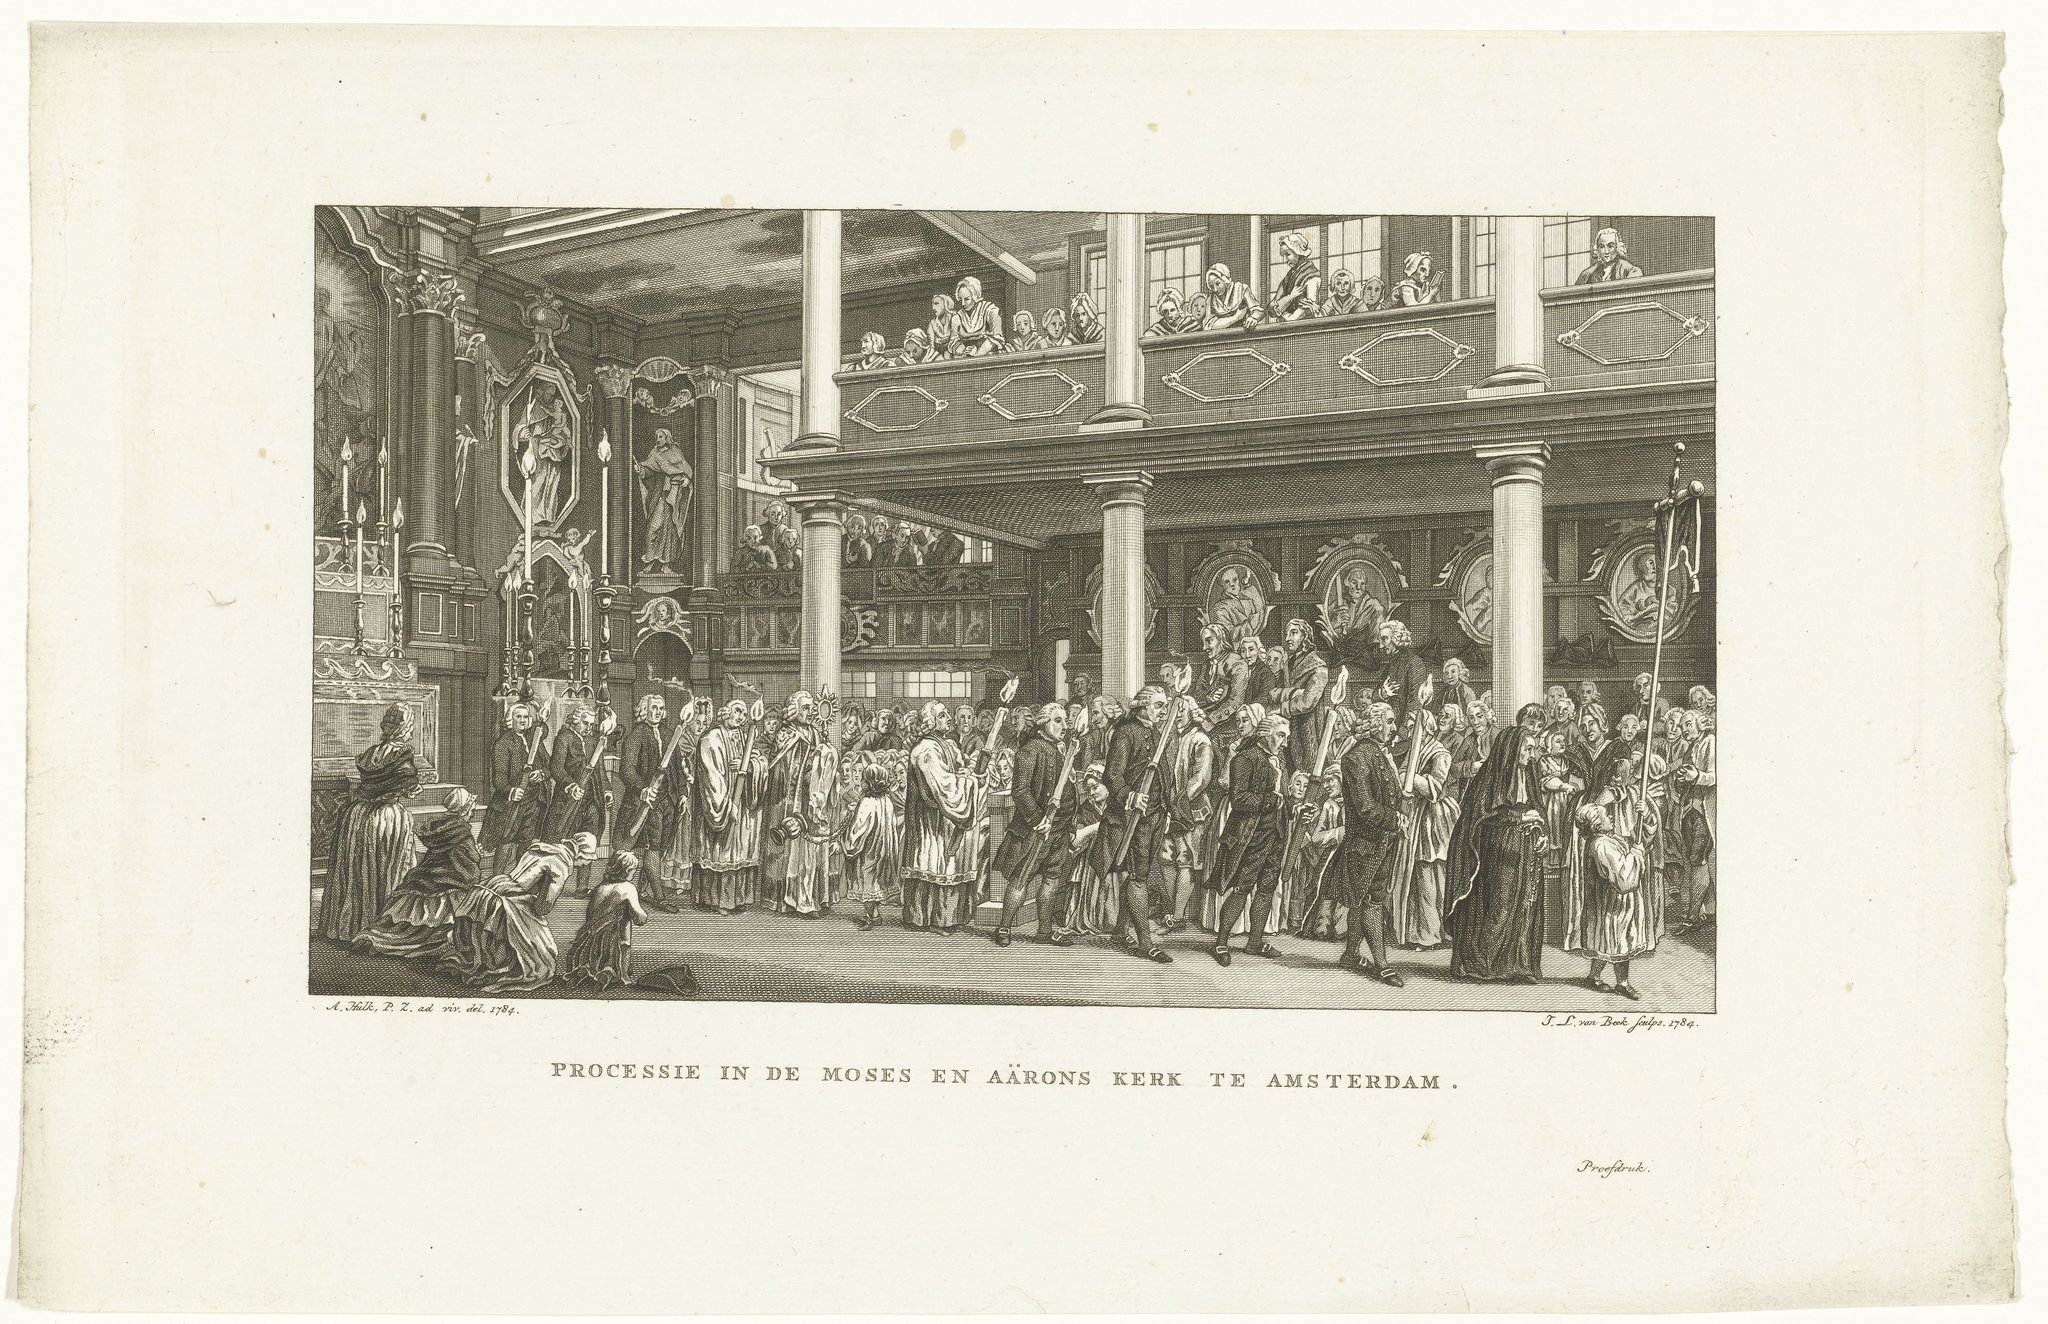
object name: print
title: Godsdiensten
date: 1784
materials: paper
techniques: engraving, etching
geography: amsterdam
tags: procession ~ christian religion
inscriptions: collector's mark: Lugt 2228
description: Prent naar tekening van A. Hulk. Prent uit serie met onbekend aantal prenten van Godsdiensten.